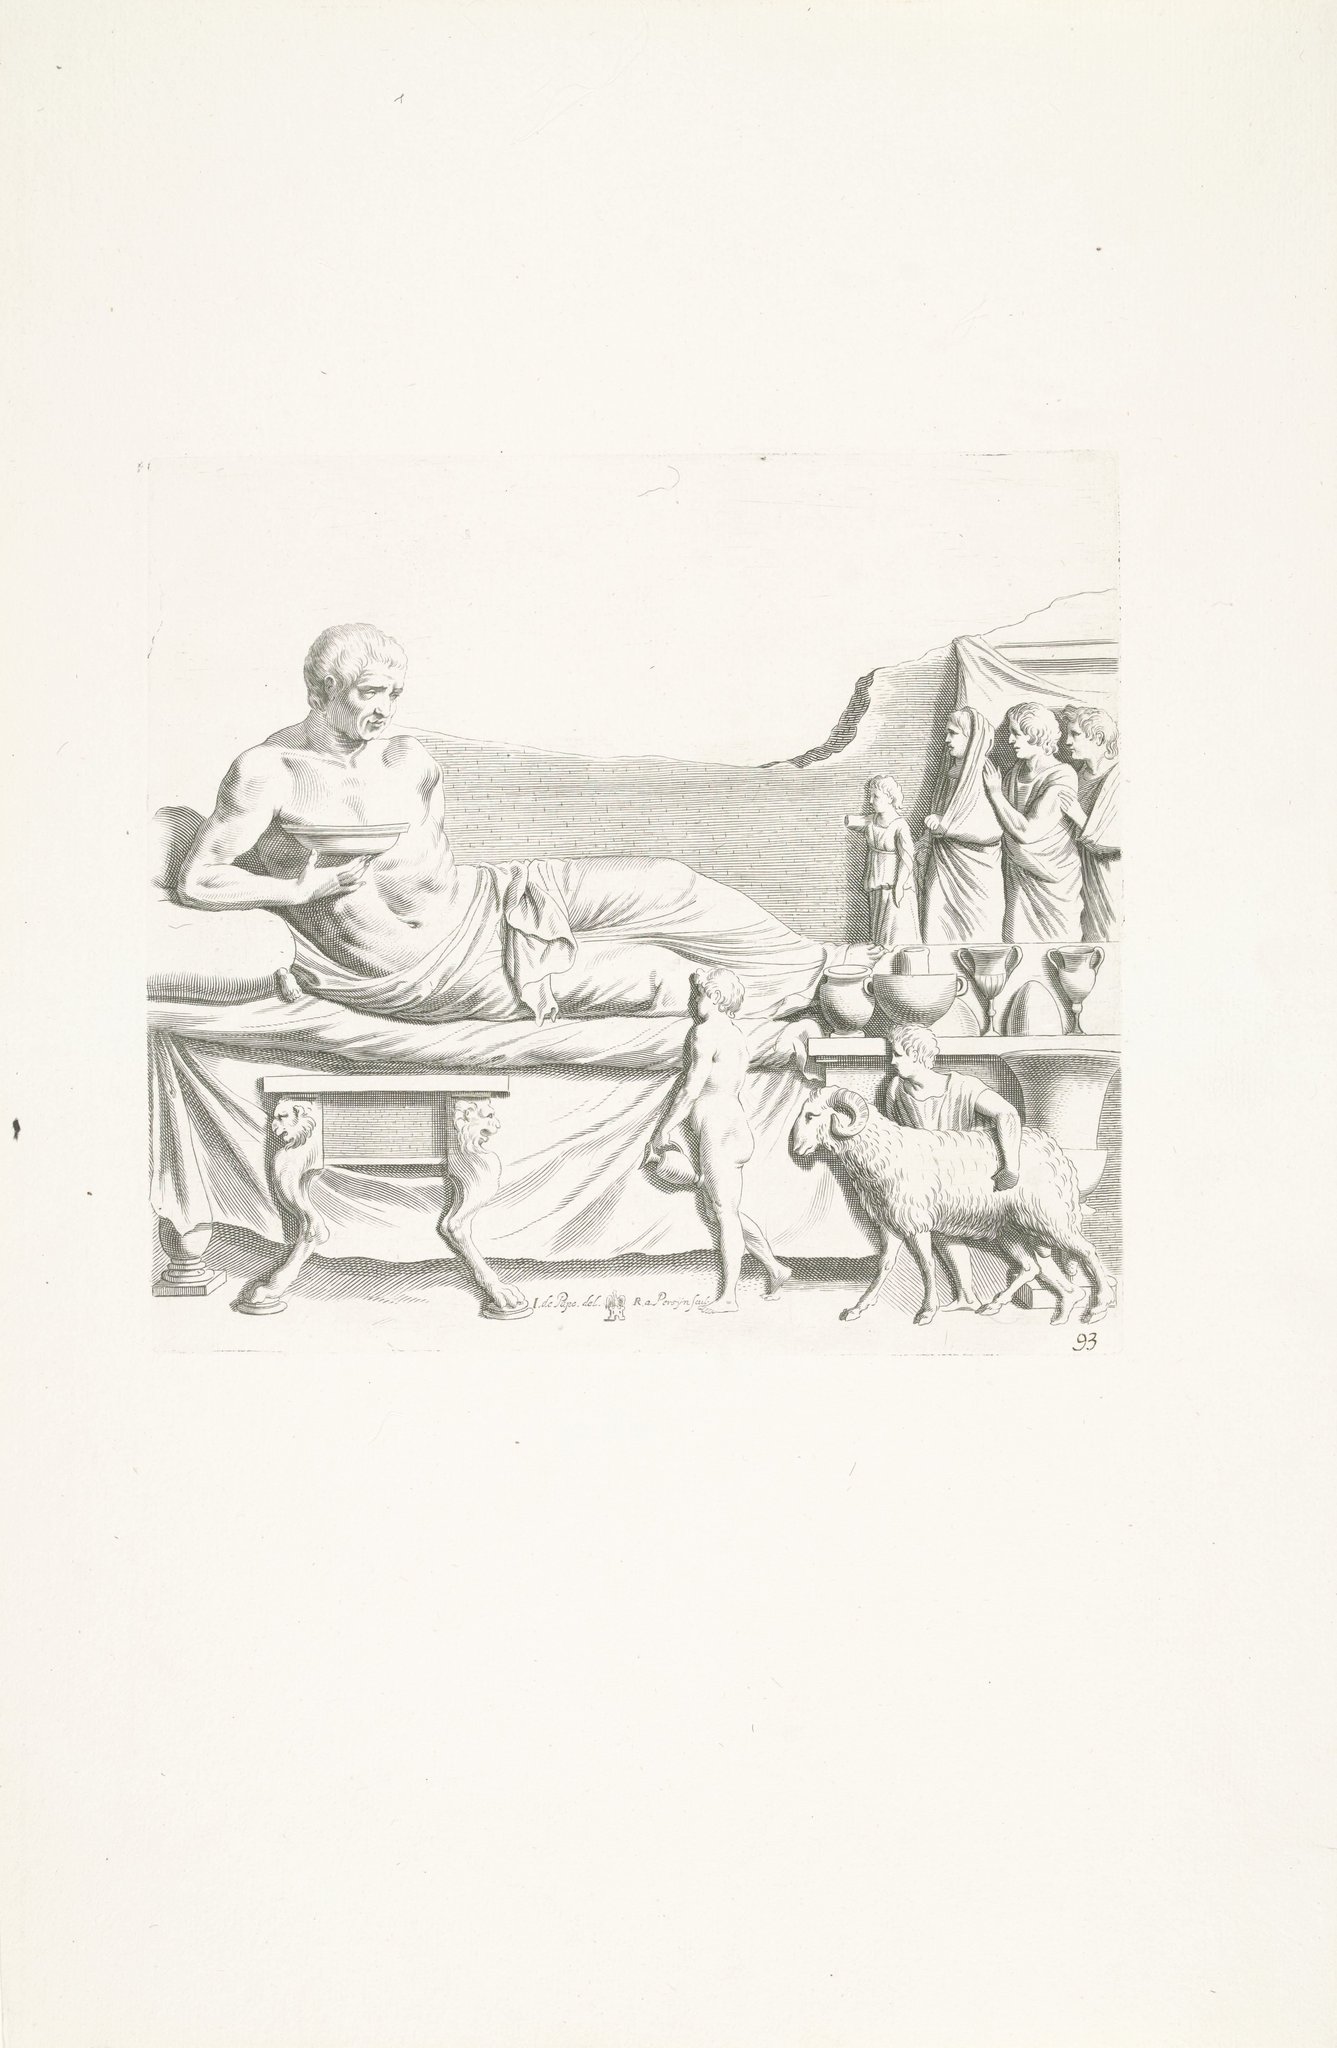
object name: print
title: Galleria Giustiniana del Marchese Vincenzo Giustiniani II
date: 1640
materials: paper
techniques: engraving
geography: rome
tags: vincenzo giustiniani (1564-1637), piece of sculpture, reproduction of a piece of sculpture, sacrifice ~ non-christian religions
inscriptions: collector's mark: Lugt 2228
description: Romeins bas-reliëf van een man, op een ligbank, met een schaal in de hand. Een ram wordt naar hem toe geleidt. Midden onder het wapenschild van Vincenzo Giustiniani. Prent uit een publicatie met reproductieprenten naar de sculpturen in de verzameling in de Galleria Giustiniani te Rome.